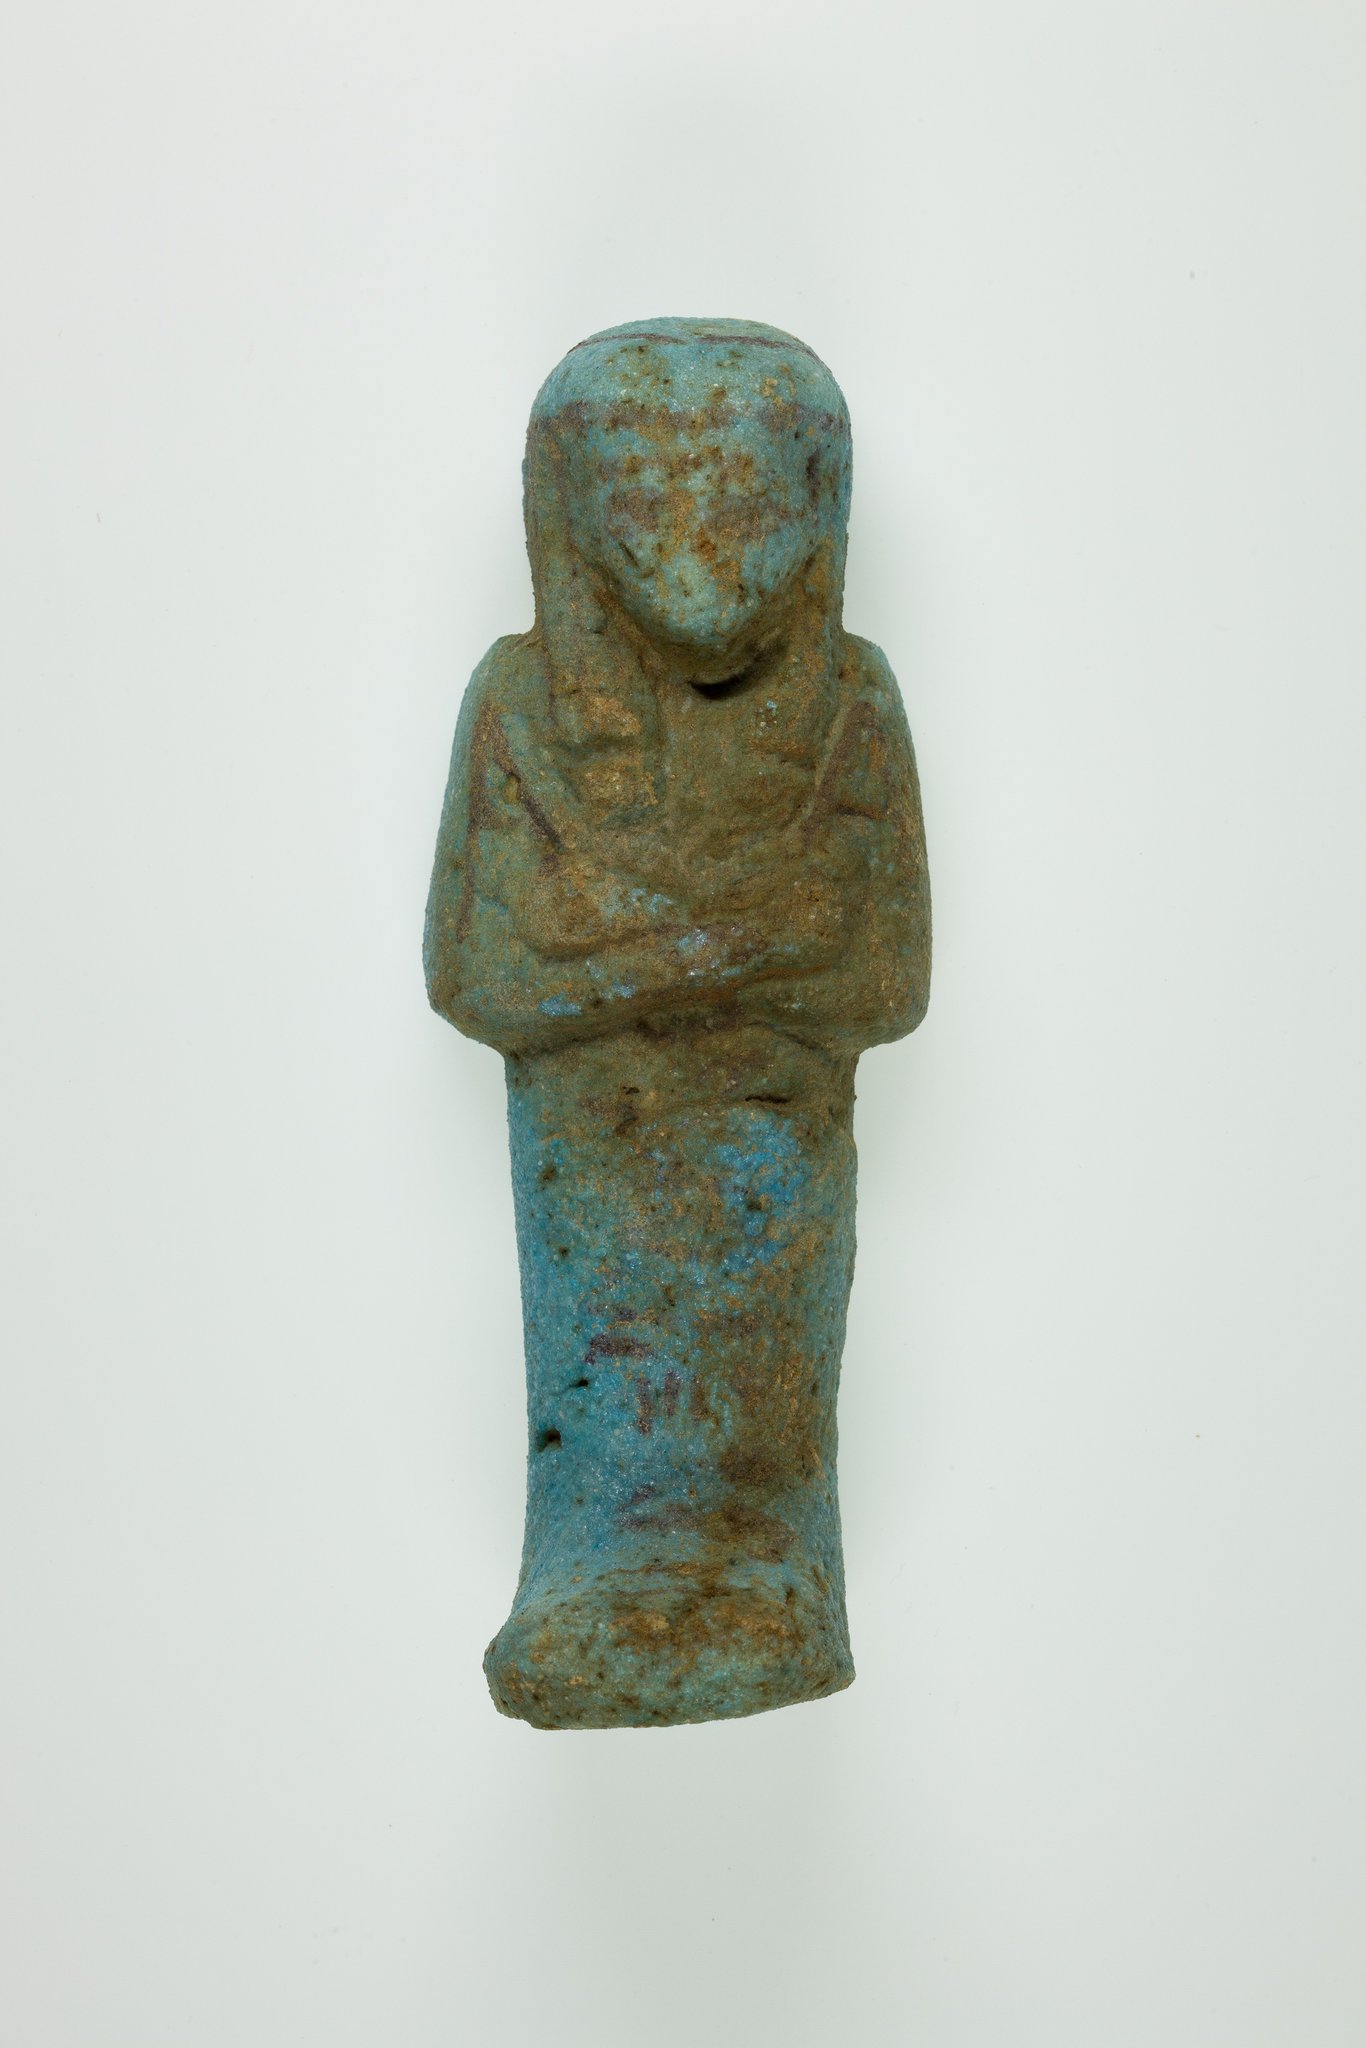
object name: worker shabti, henettawy c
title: Worker Shabti of Henettawy (C), Daughter of Isetemkheb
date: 990-970 BCE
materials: faience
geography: egypt